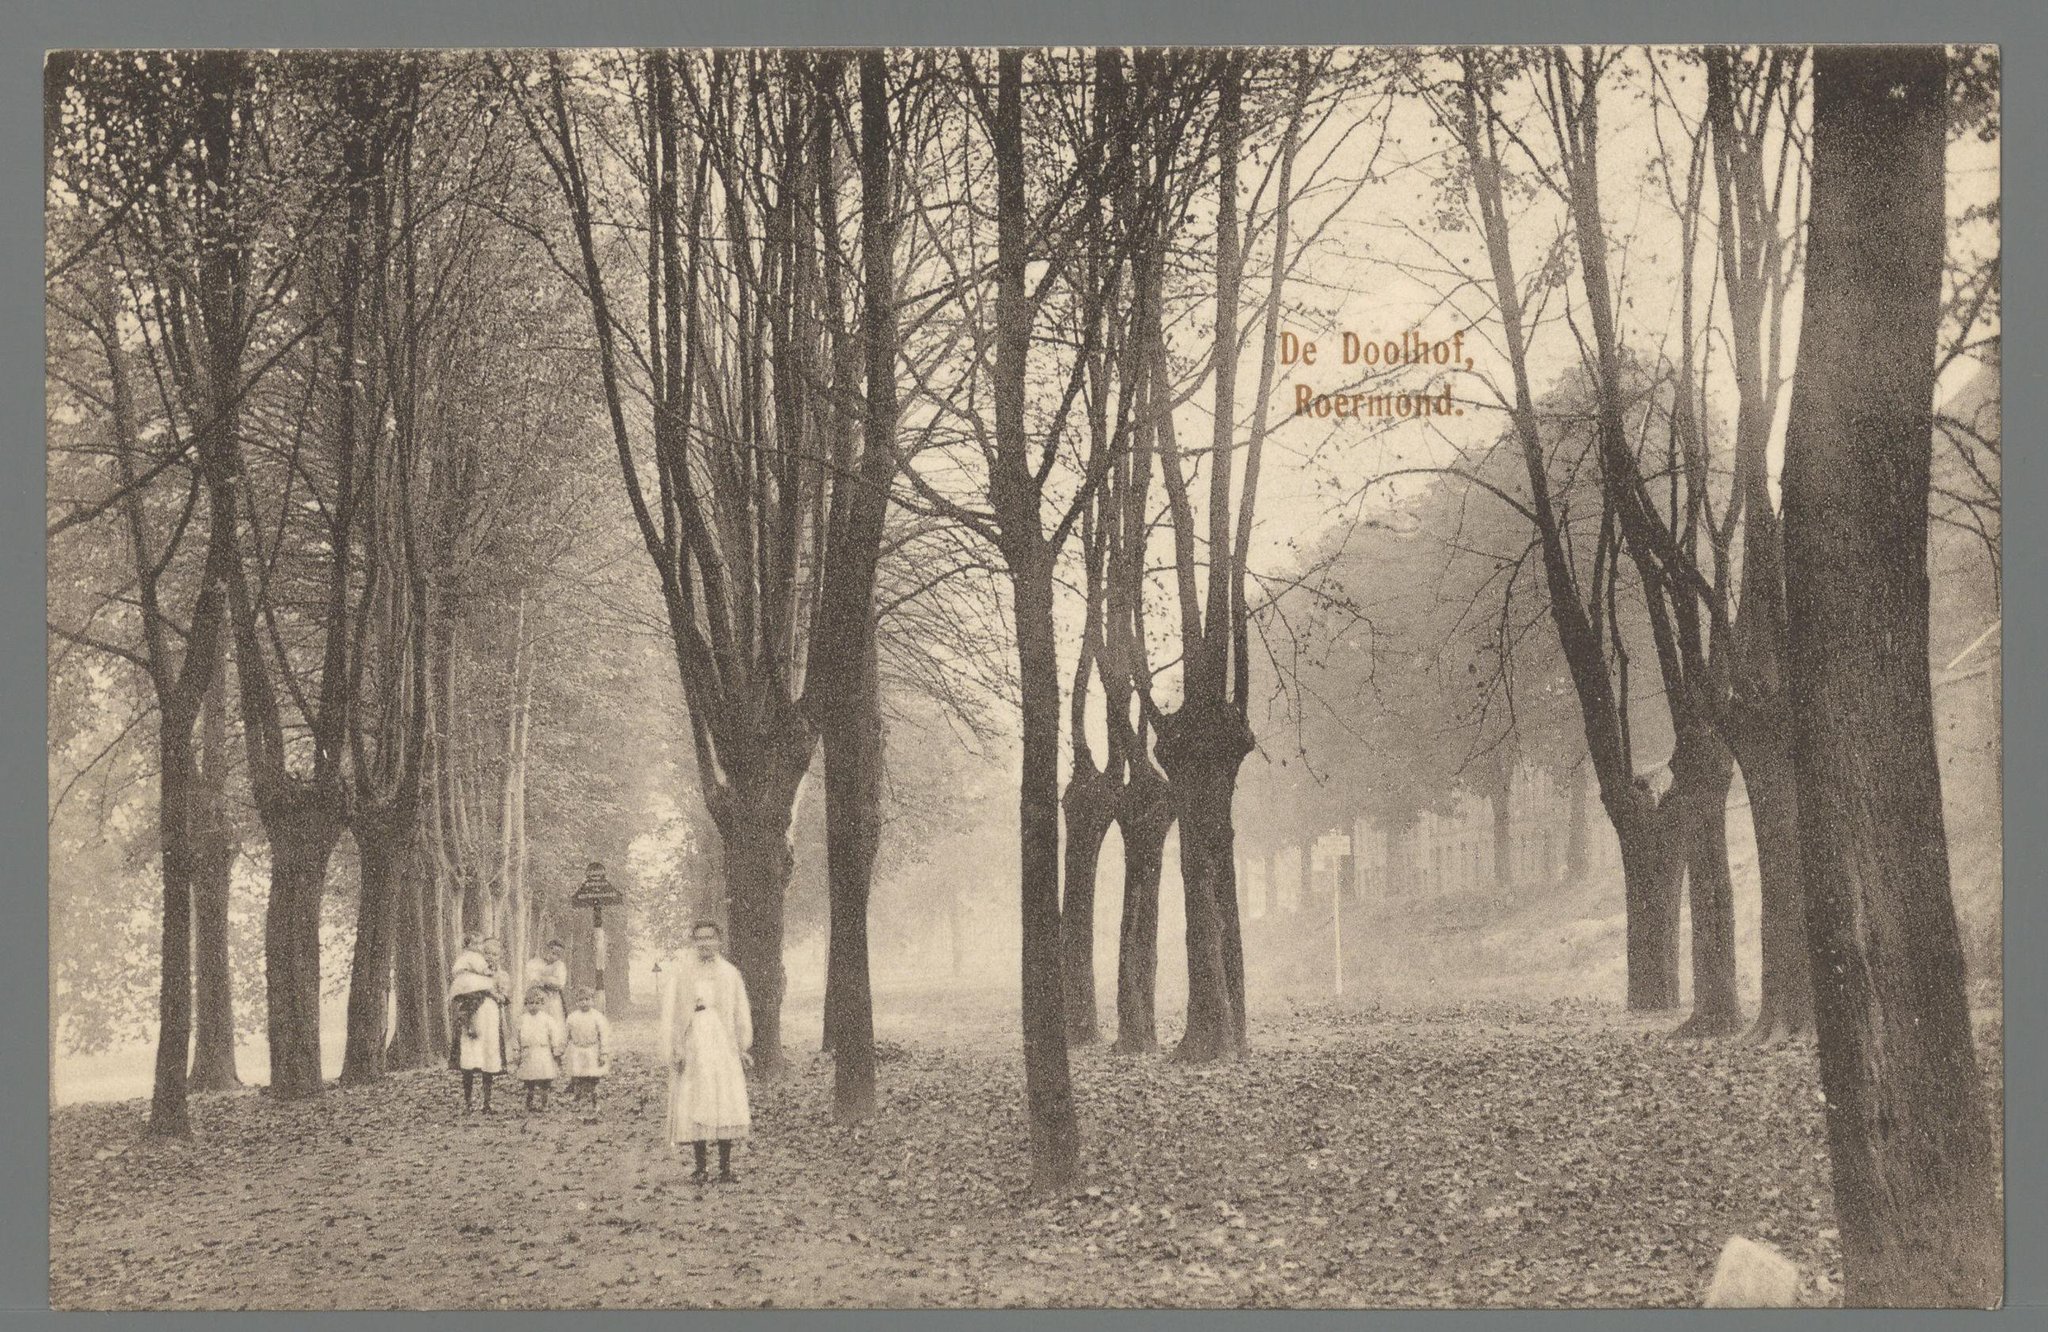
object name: ansichtkaart, prentbriefkaart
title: De Doolhof, Roermond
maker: Anonymous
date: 1905-1930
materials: cardboard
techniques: photograph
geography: roermond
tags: forest, wood